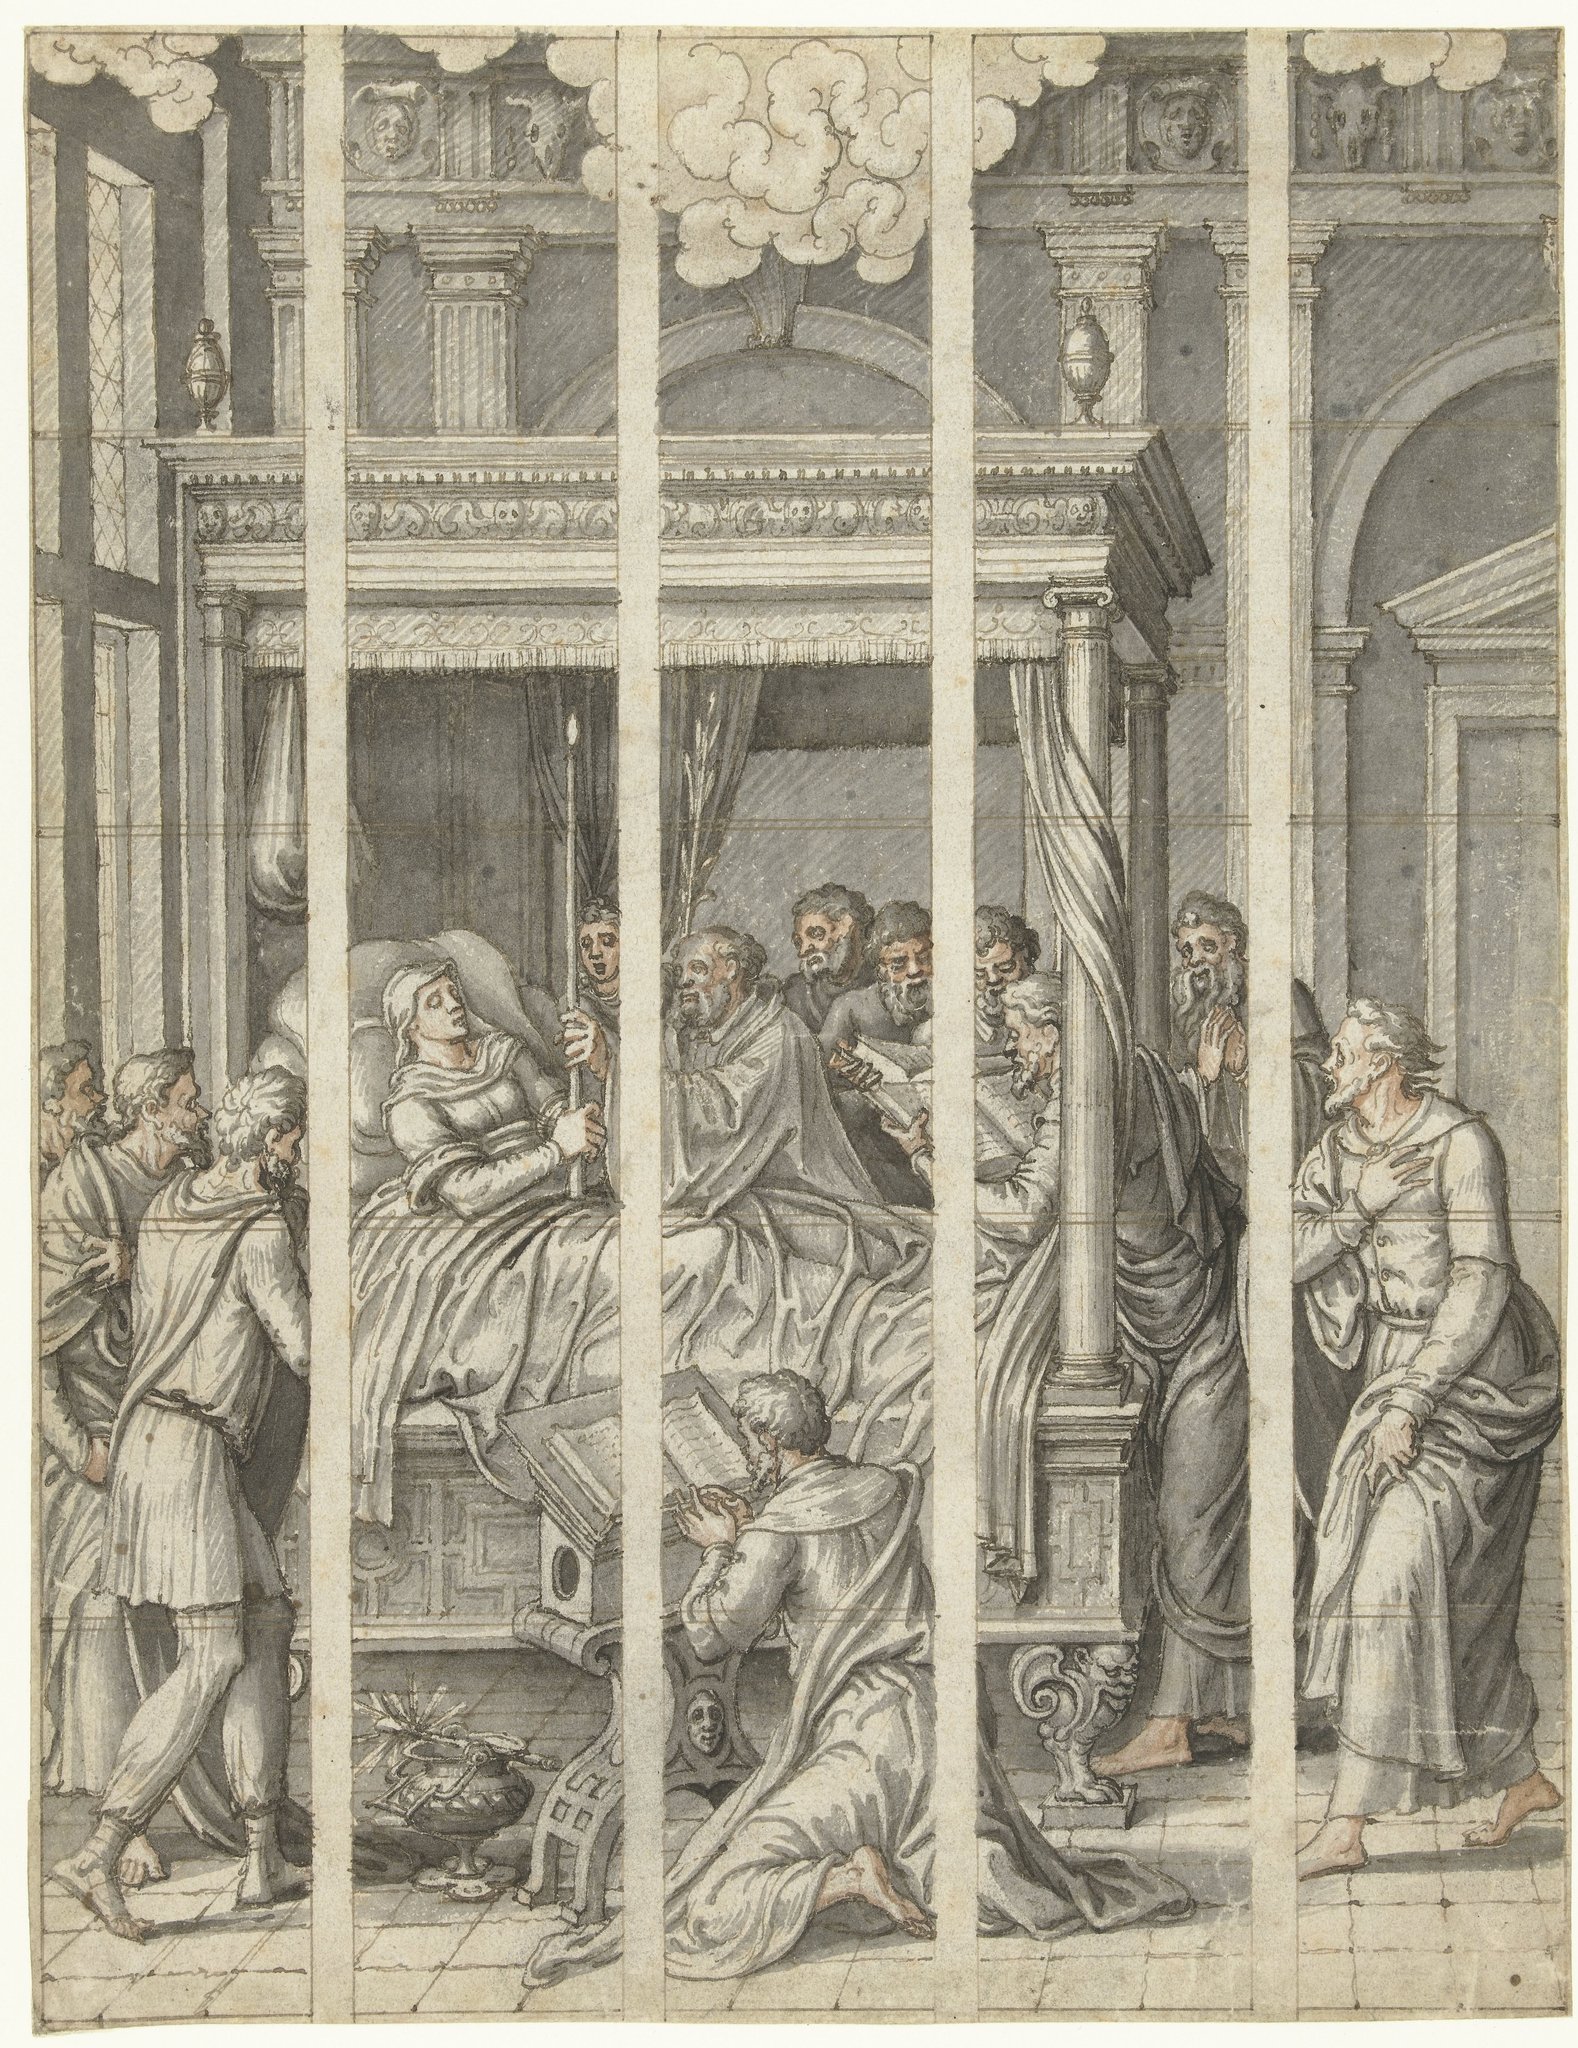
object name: drawing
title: Dood van de maagd Maria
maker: dirck pietersz. crabeth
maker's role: draughtsman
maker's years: 1520-1574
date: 1561-1565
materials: ink, paper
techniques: brush, pen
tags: the dormition: mary on her deathbed; the apostles are gathered around her (john the evangelist may be shown sleeping or dreaming)